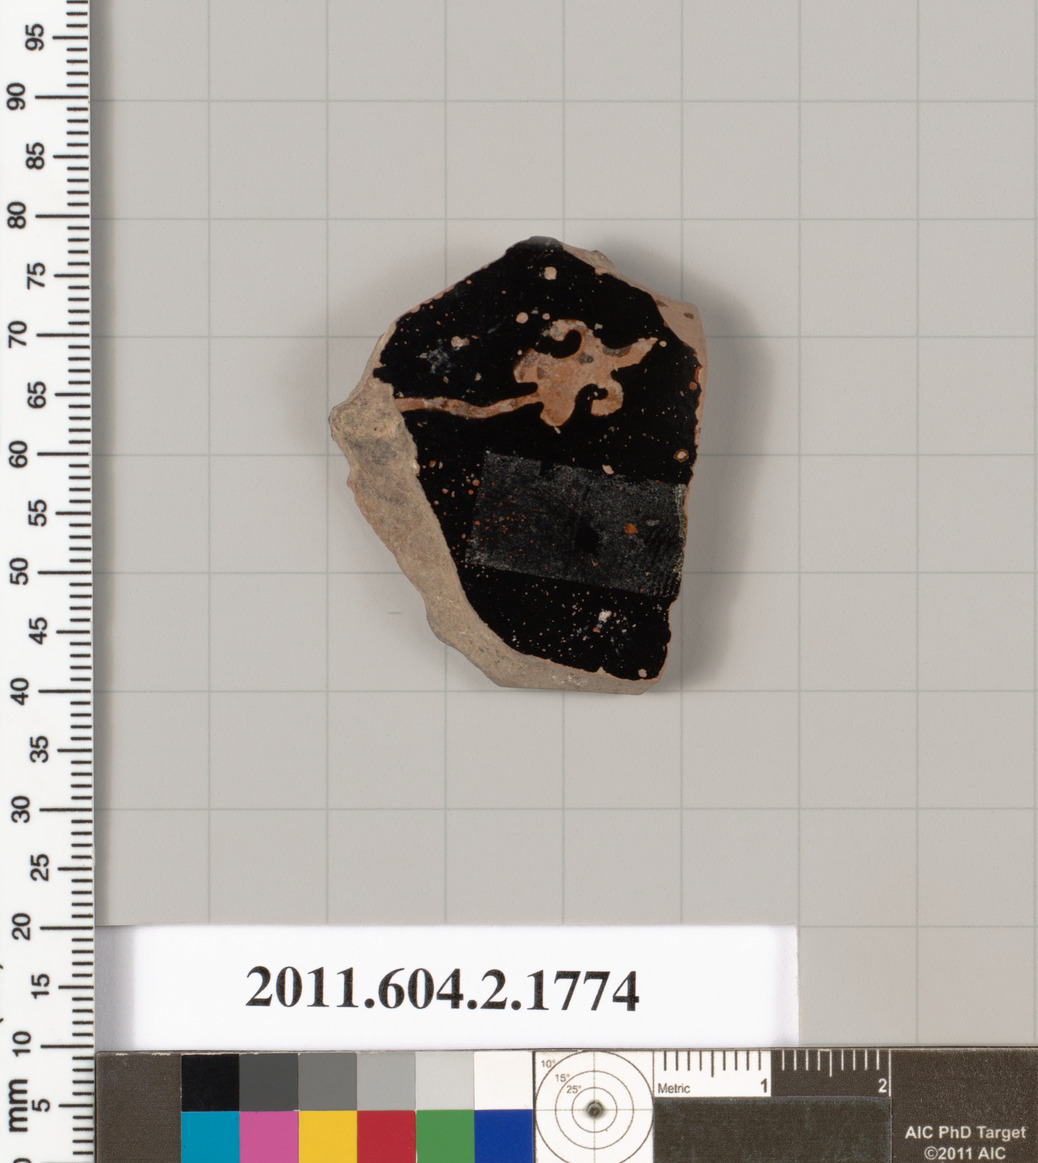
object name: skyphos fragment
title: Terracotta fragment of a skyphos (deep drinking cup)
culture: greek, attic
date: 460-440 BCE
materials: terracotta